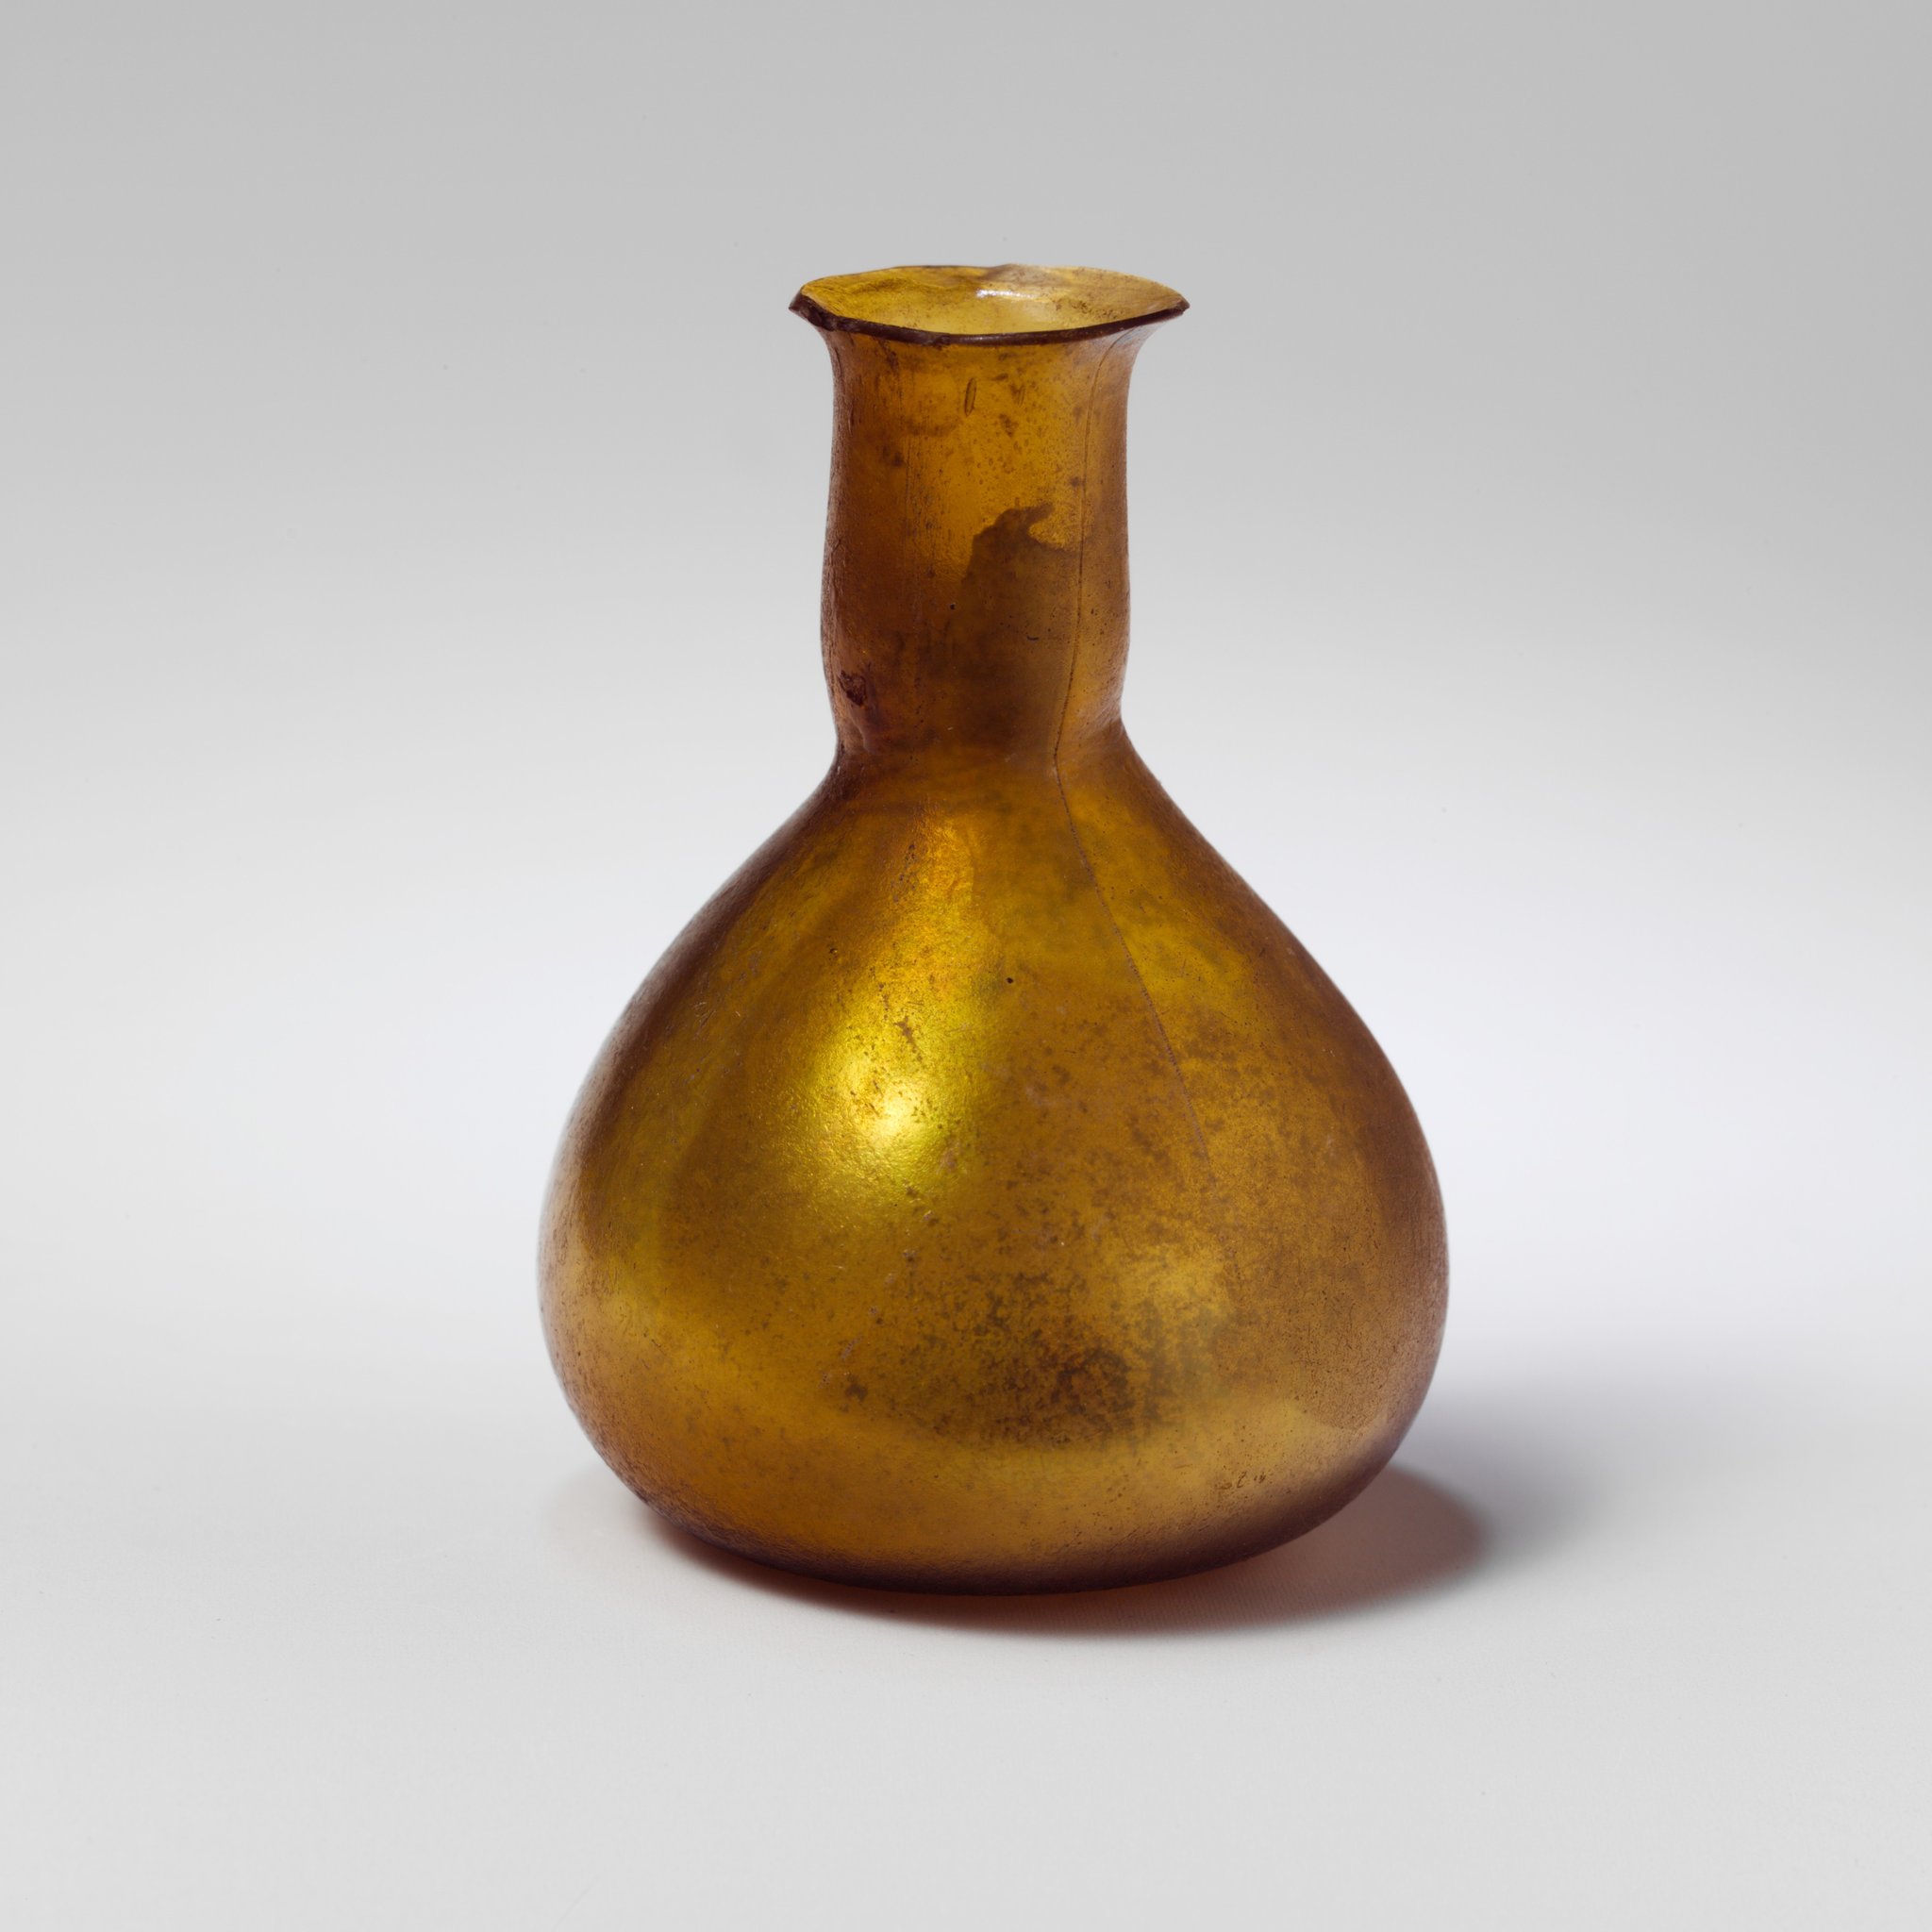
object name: perfume bottle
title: Glass perfume bottle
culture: roman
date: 1-100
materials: glass